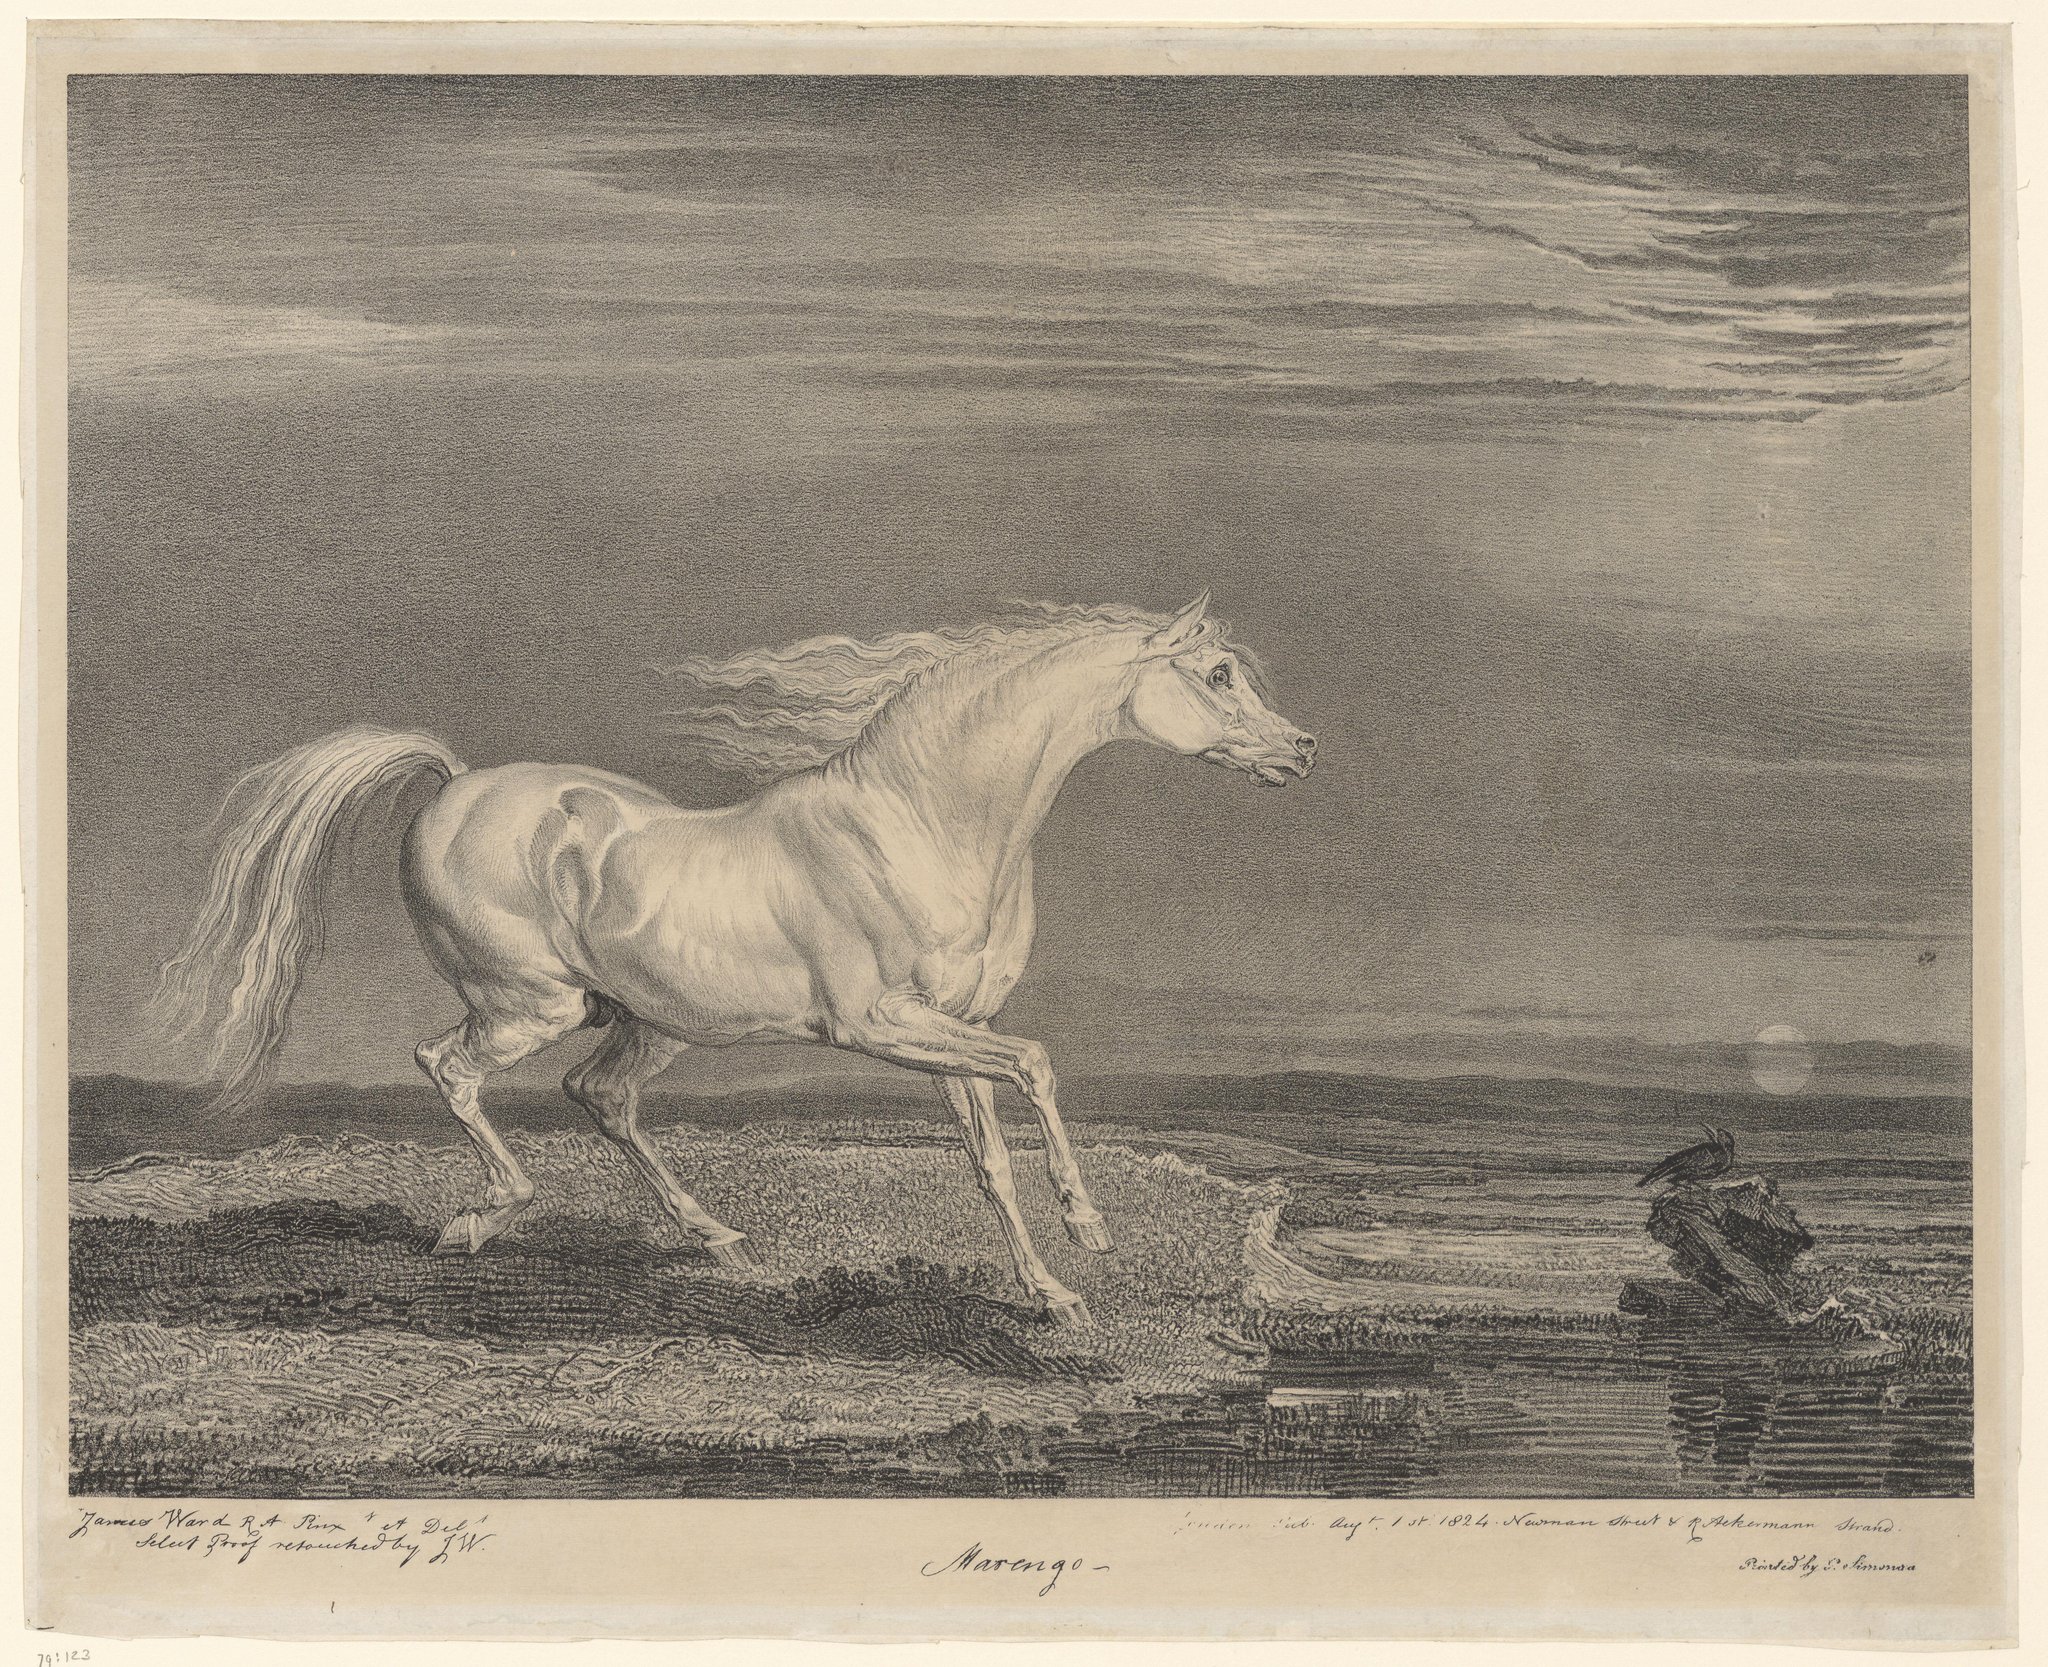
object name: print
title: Voorstellingen van bekende paarden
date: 1824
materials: paper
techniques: lithograph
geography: london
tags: horse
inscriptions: mark: ‘G. [...]’, collector's mark: Lugt 2228, collector's mark: Lugt 2760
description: Marengo was het paard van Napoleon Bonaparte.